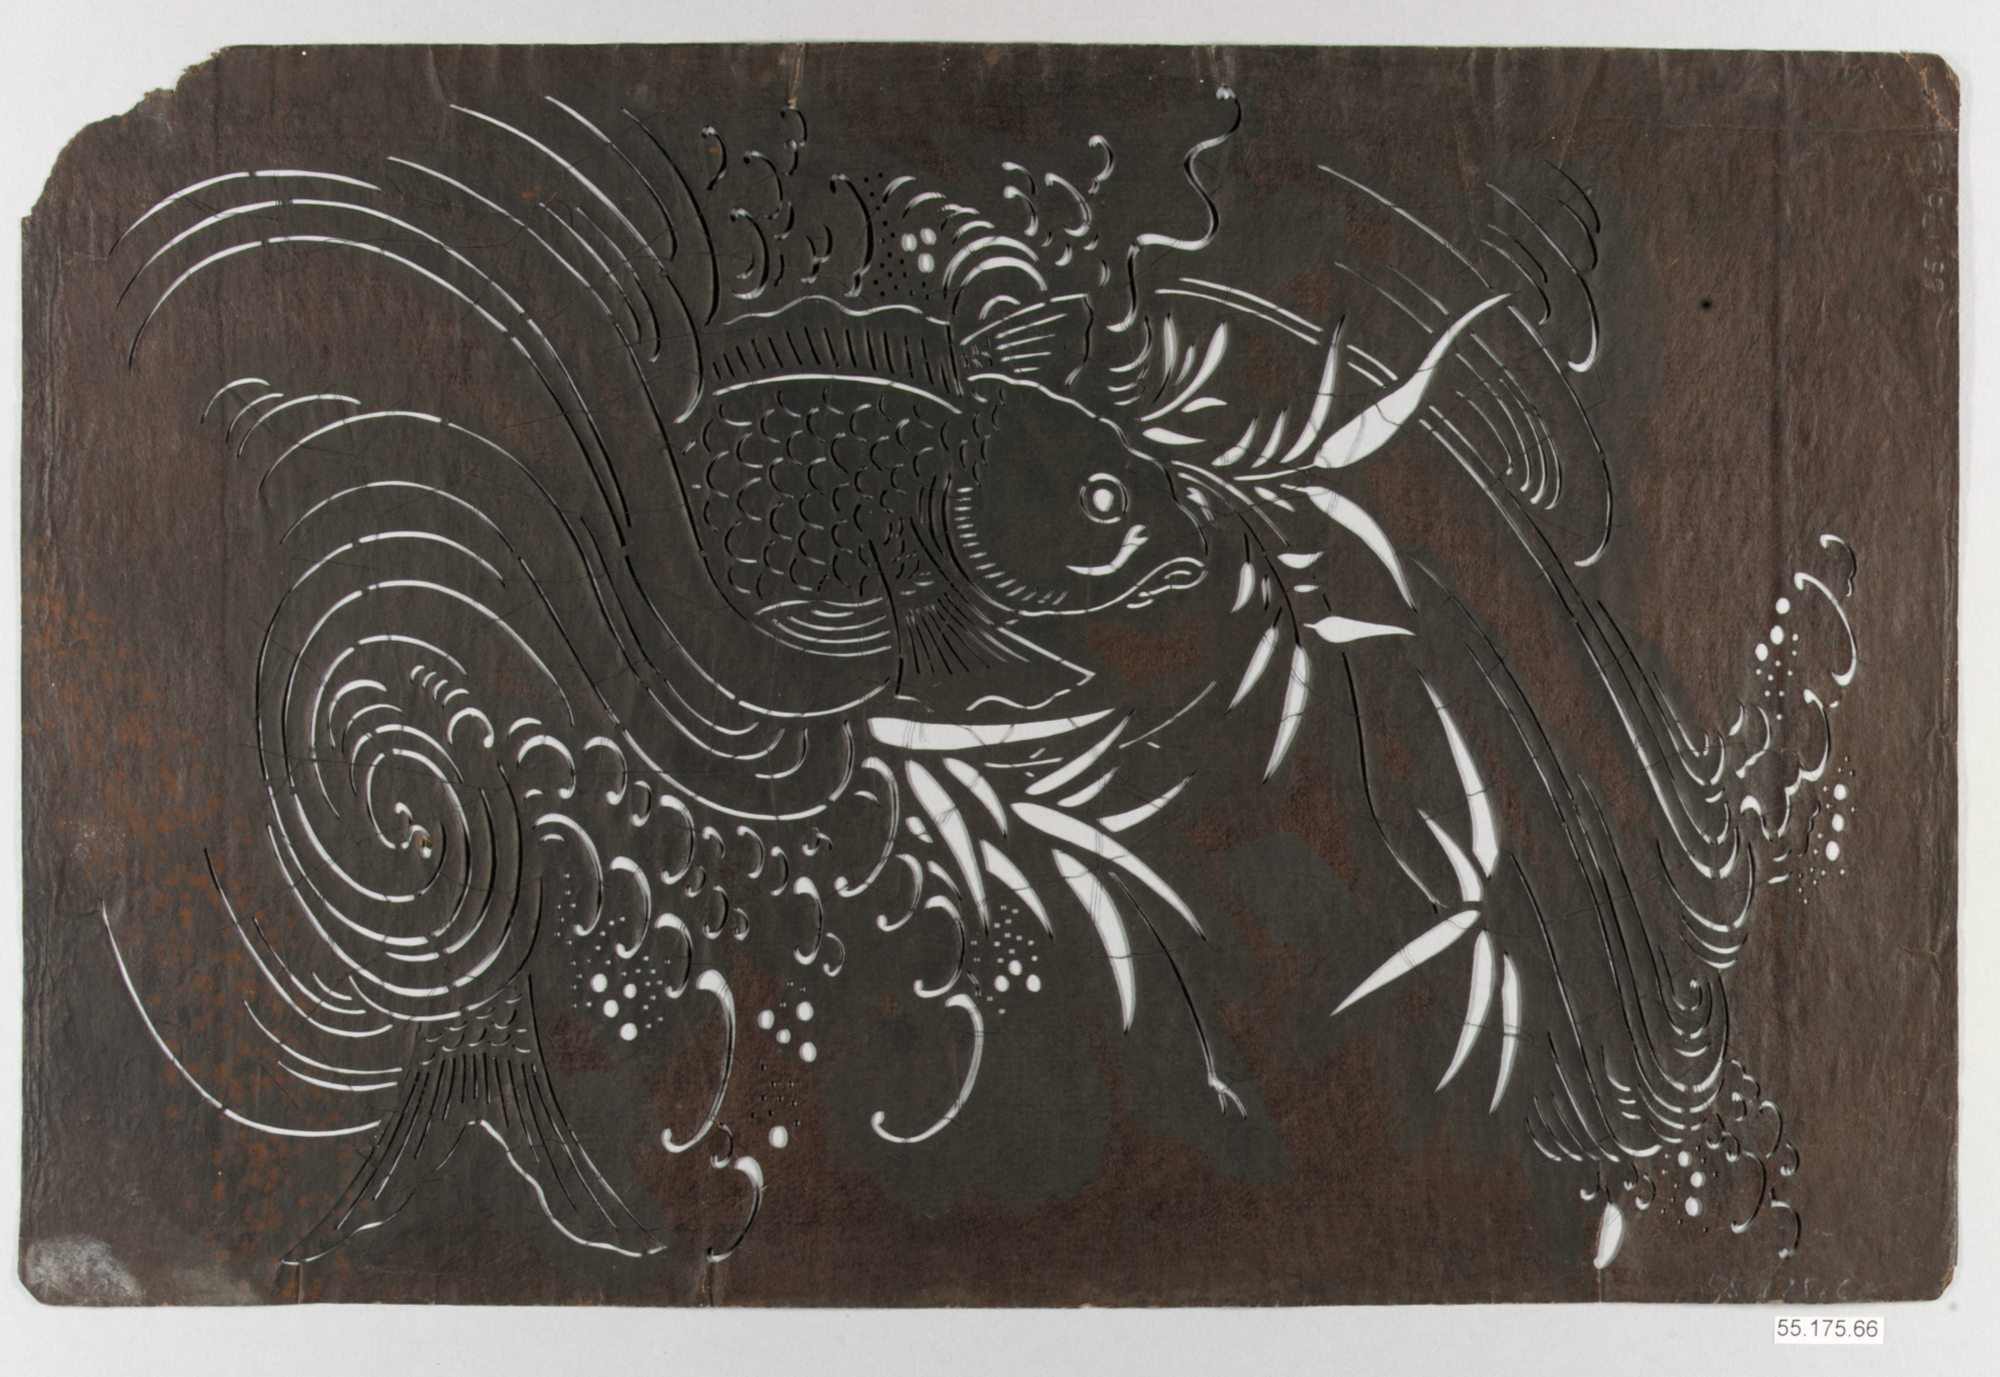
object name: stencil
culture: japanese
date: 1801-1900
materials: paper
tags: fish,waves